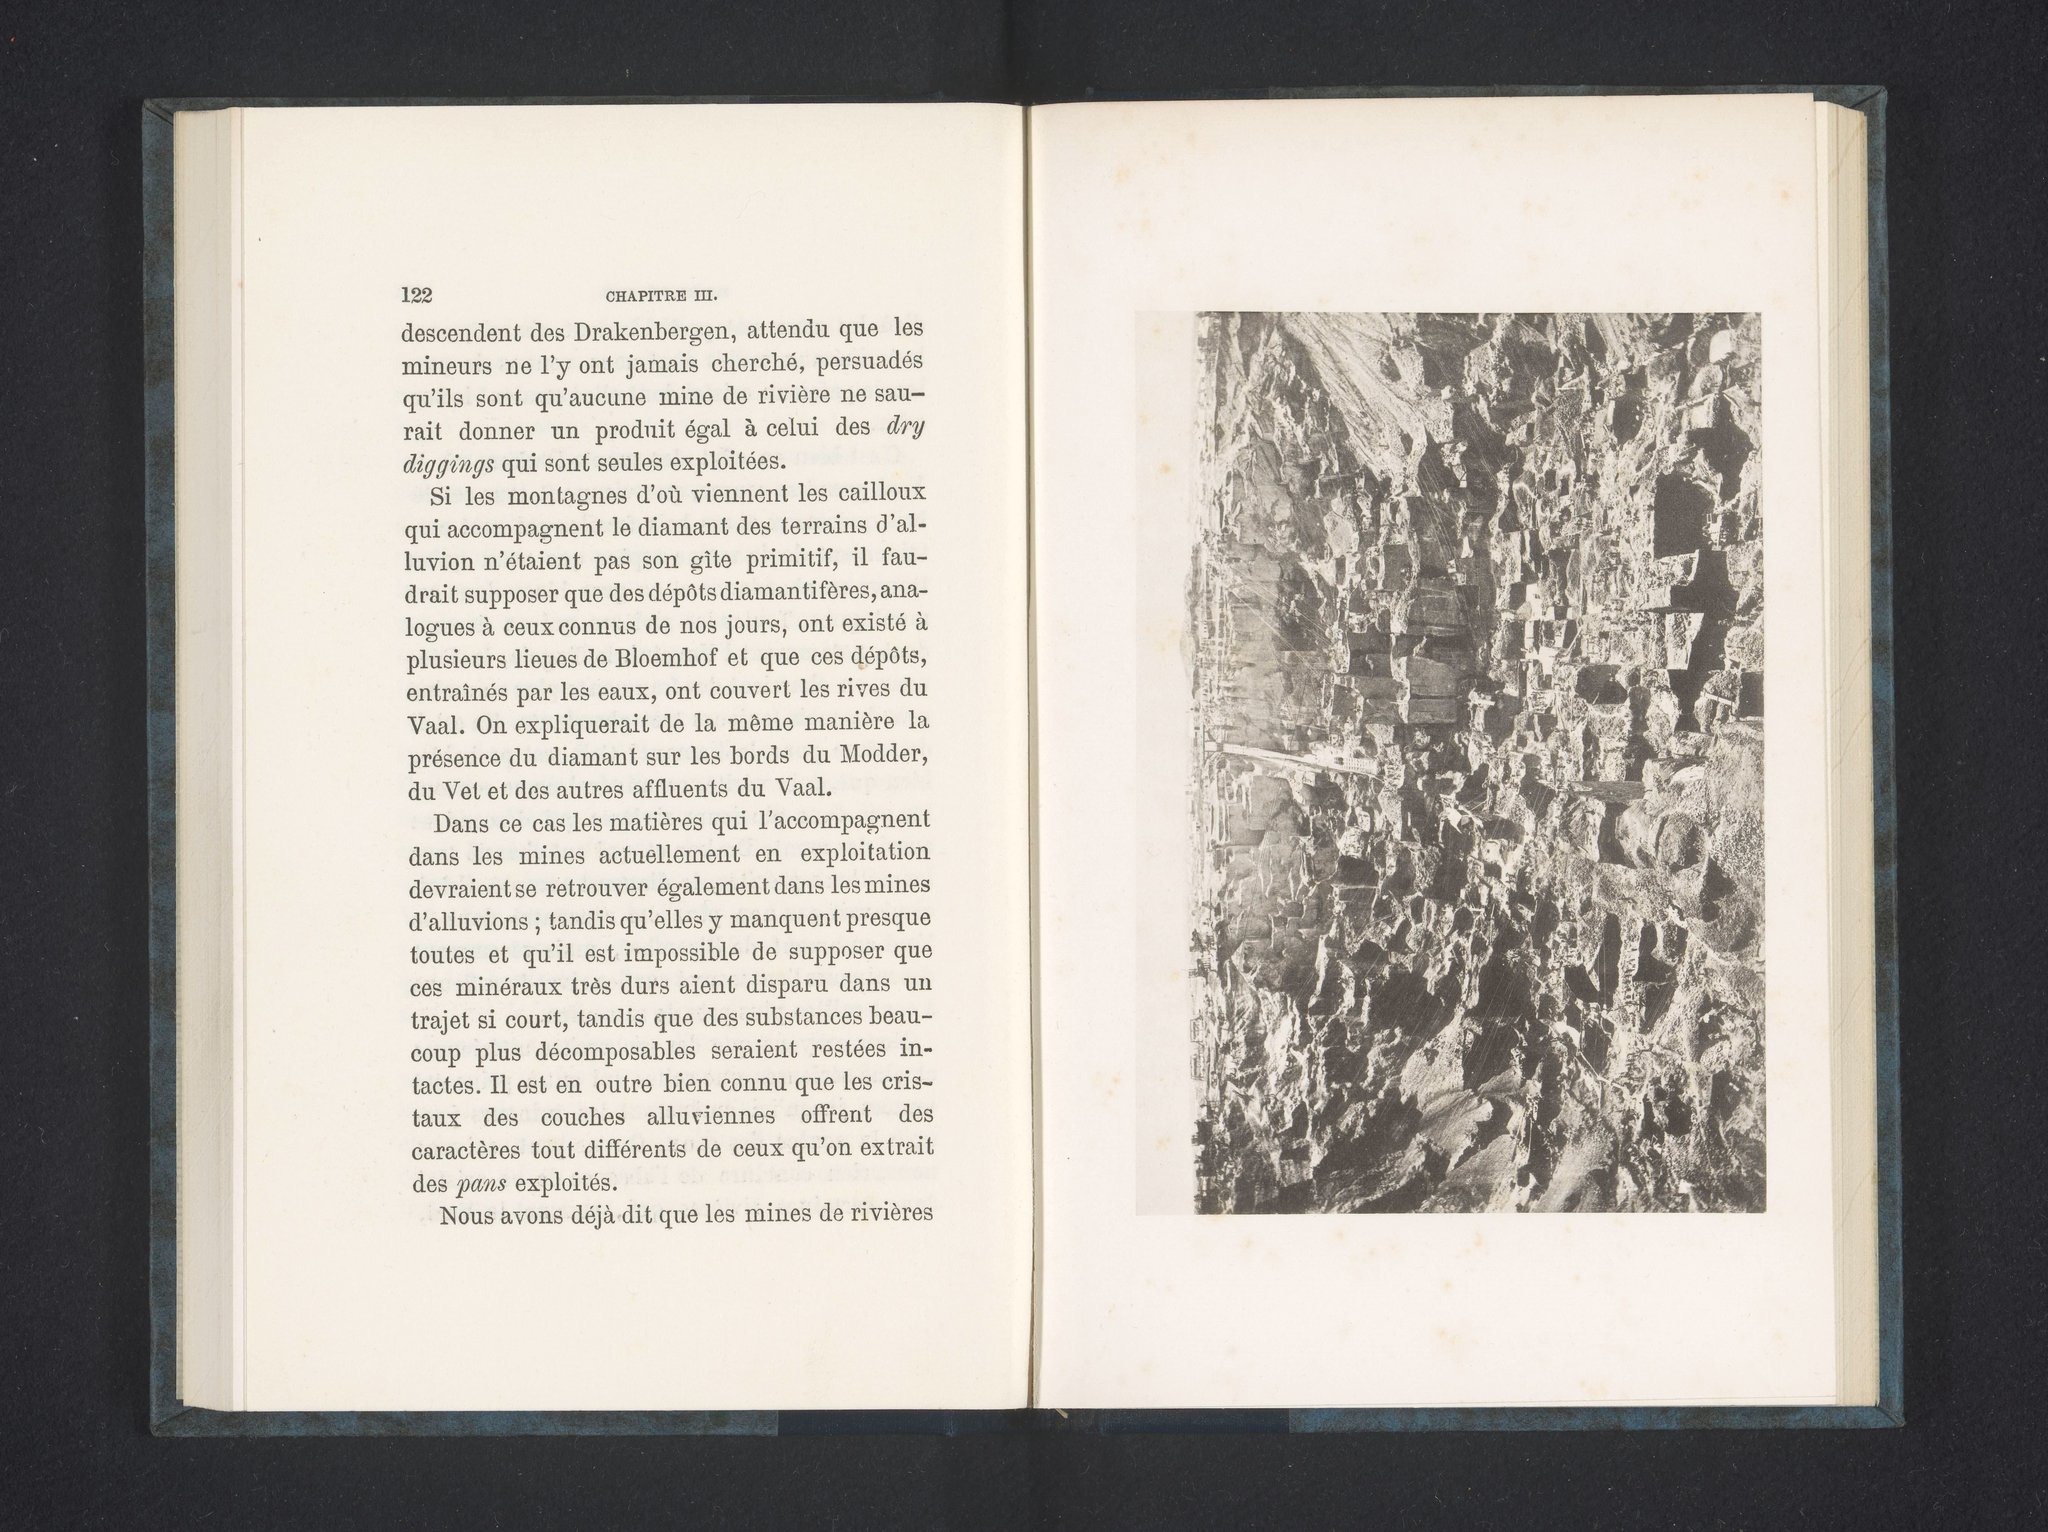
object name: photomechanical print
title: Gezicht op een diamantmijn nabij Kimberley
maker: Anonymous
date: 1875-1880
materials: paper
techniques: photograph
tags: mine